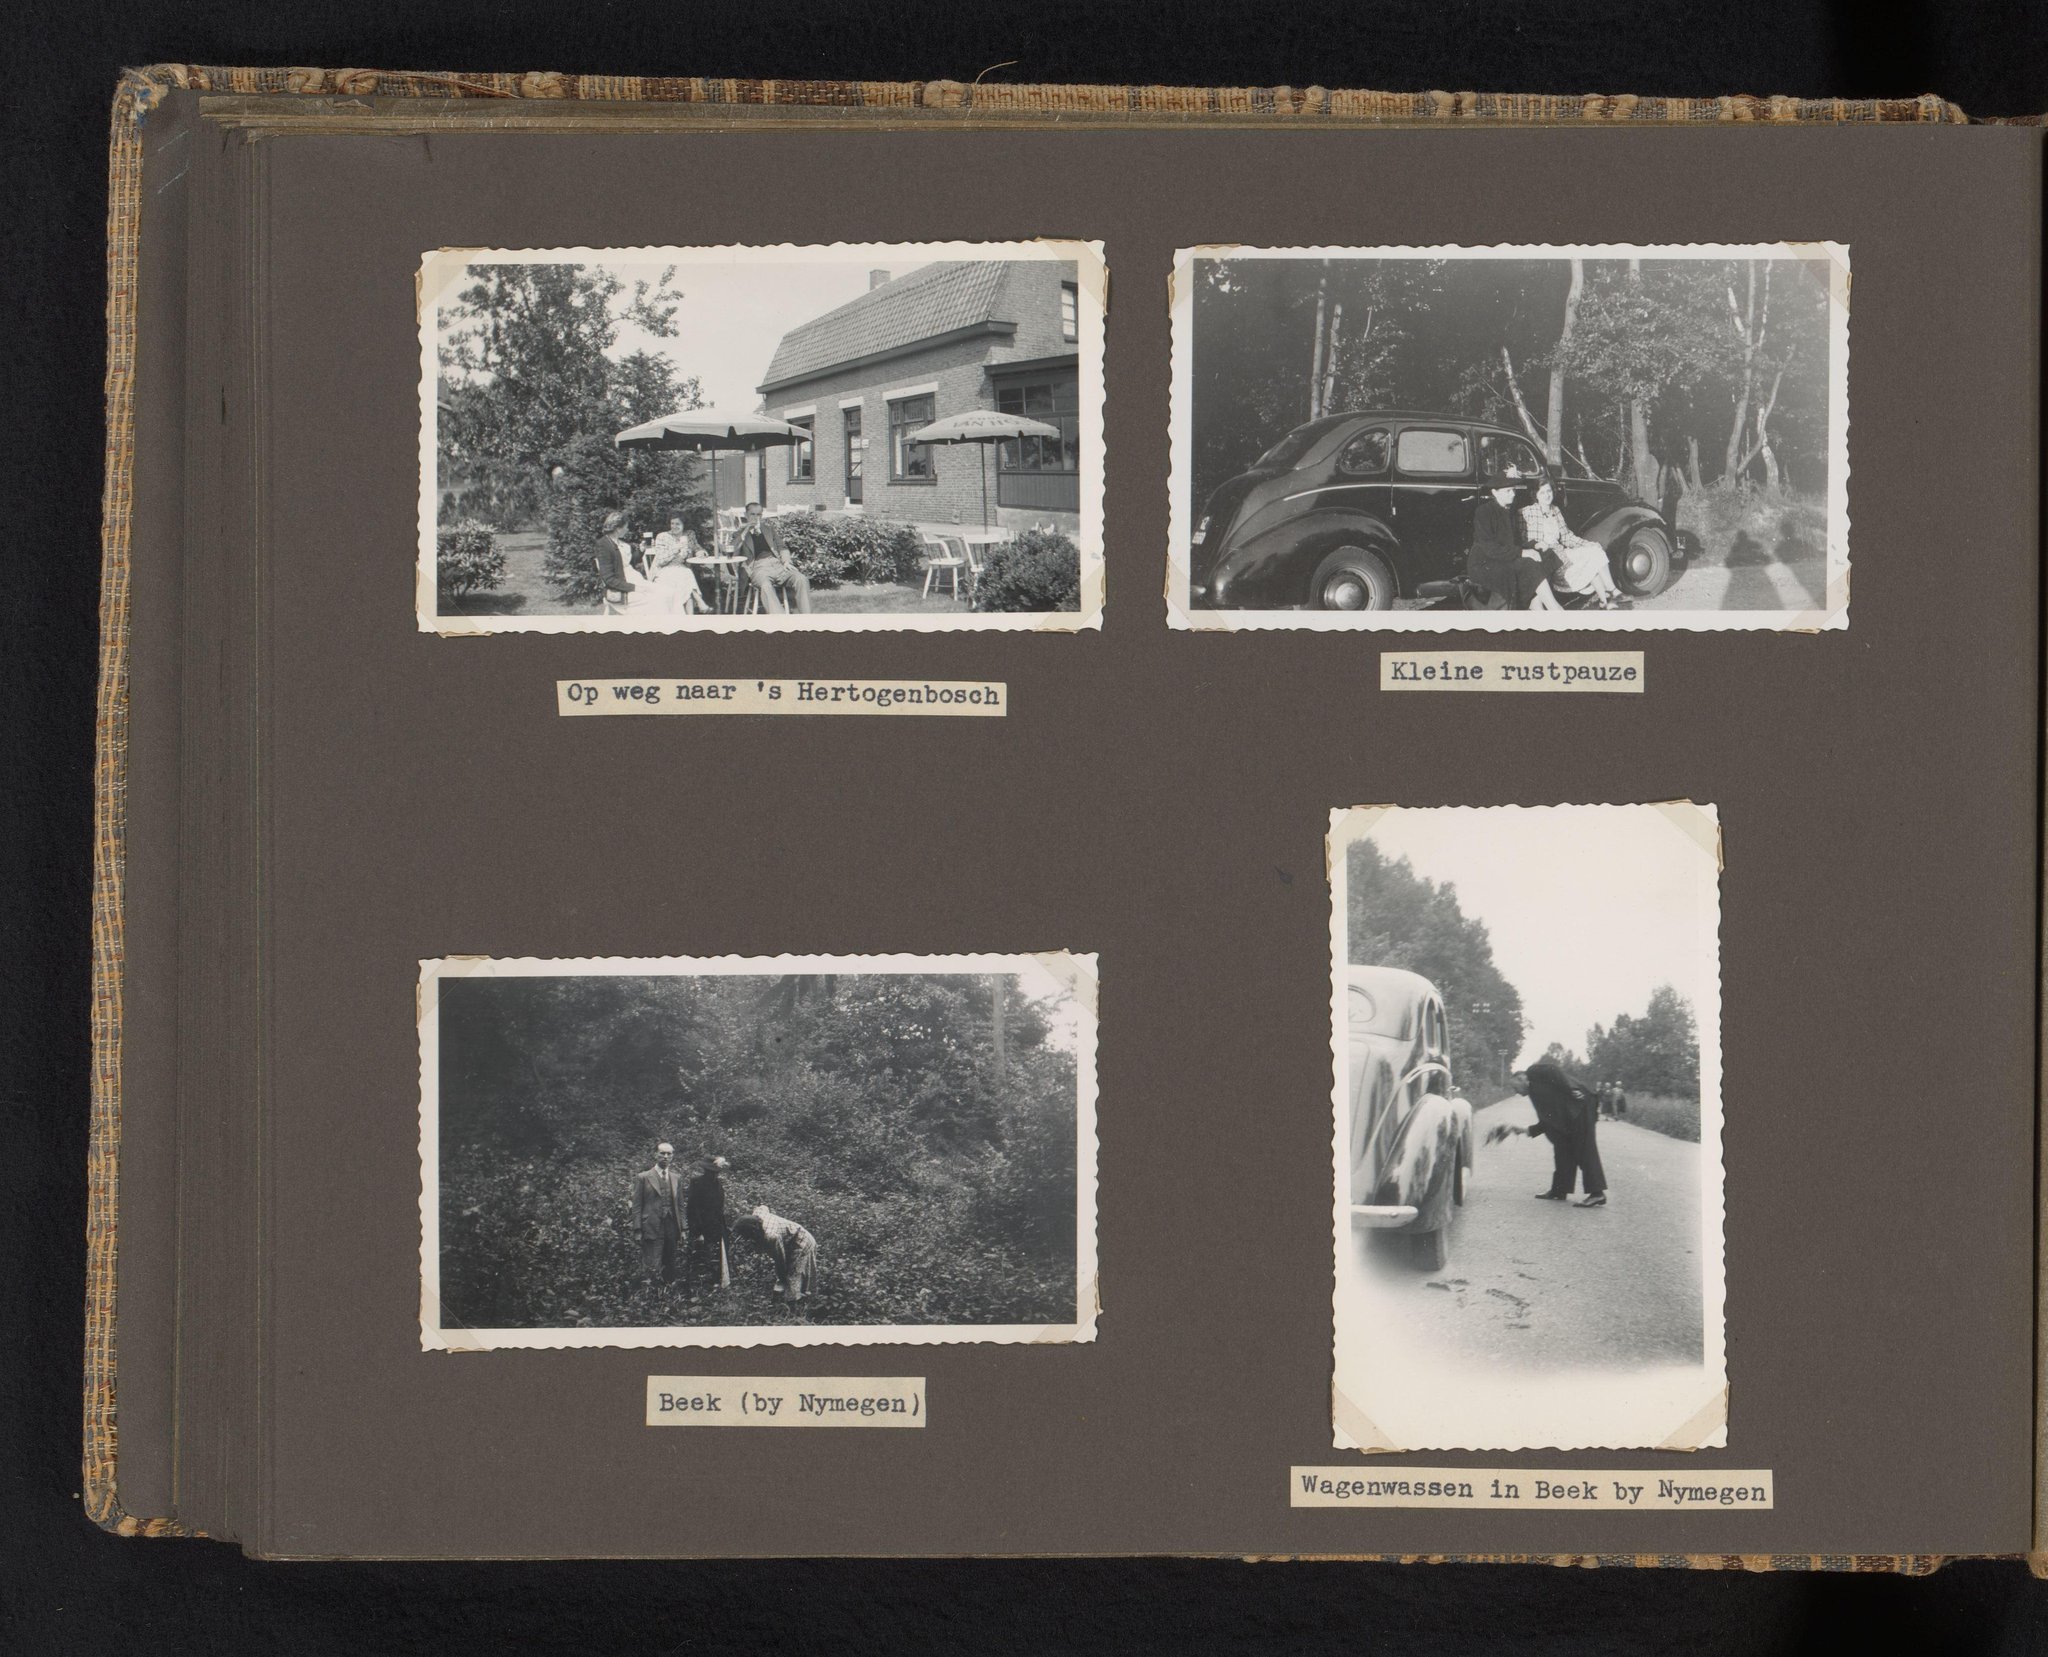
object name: photograph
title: Onderweg en bij Beek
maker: Anonymous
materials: paper, photographic support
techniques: gelatin silver print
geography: netherlands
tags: the family travelling, on holiday, outing, pleasure trip, automobile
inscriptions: inscription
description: Albumblad met vier foto's onderweg naar Den Bosch en bij Beek. Onder de foto's uitgeknipte papiertjes met getypte opschriften. Onderdeel van het eerste fotoalbum met foto's van de twee fietstochten van vader en zoon door Nederland in september 1939 en juli 1940 en een autotrip met het gezin door Nederland, België en Luxemburg in juni 1949.